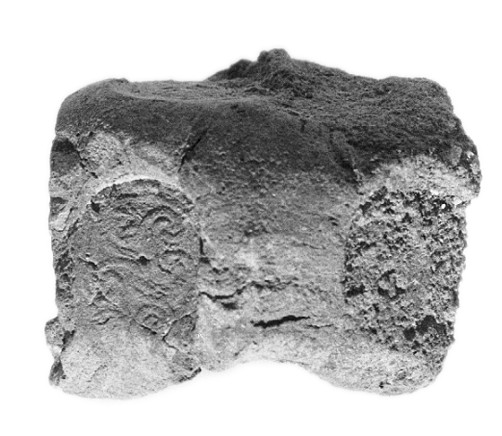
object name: sealing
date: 1981-1640 BCE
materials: mud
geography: egypt